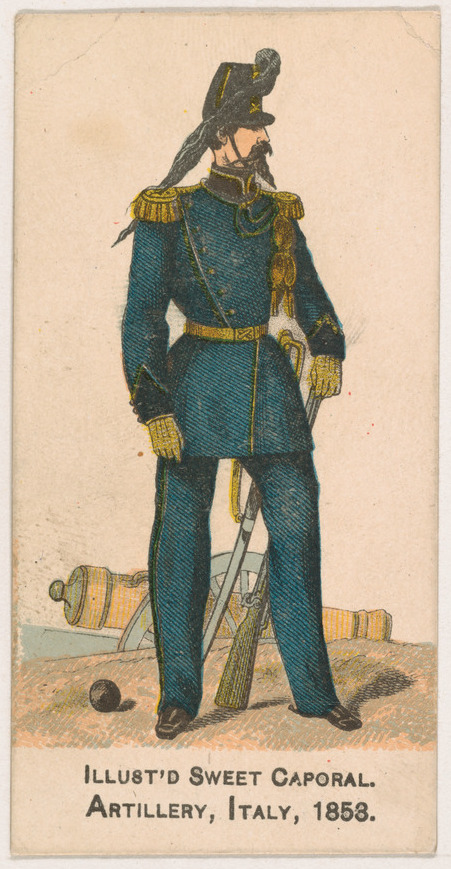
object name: print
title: Artillery, Italy, 1883, from the Military Series (N224) issued by Kinney Tobacco Company to promote Sweet Caporal Cigarettes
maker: kinney brothers tobacco company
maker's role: publisher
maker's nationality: american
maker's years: 1869-2011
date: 1888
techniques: color lithograph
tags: military,firearms,men,profiles